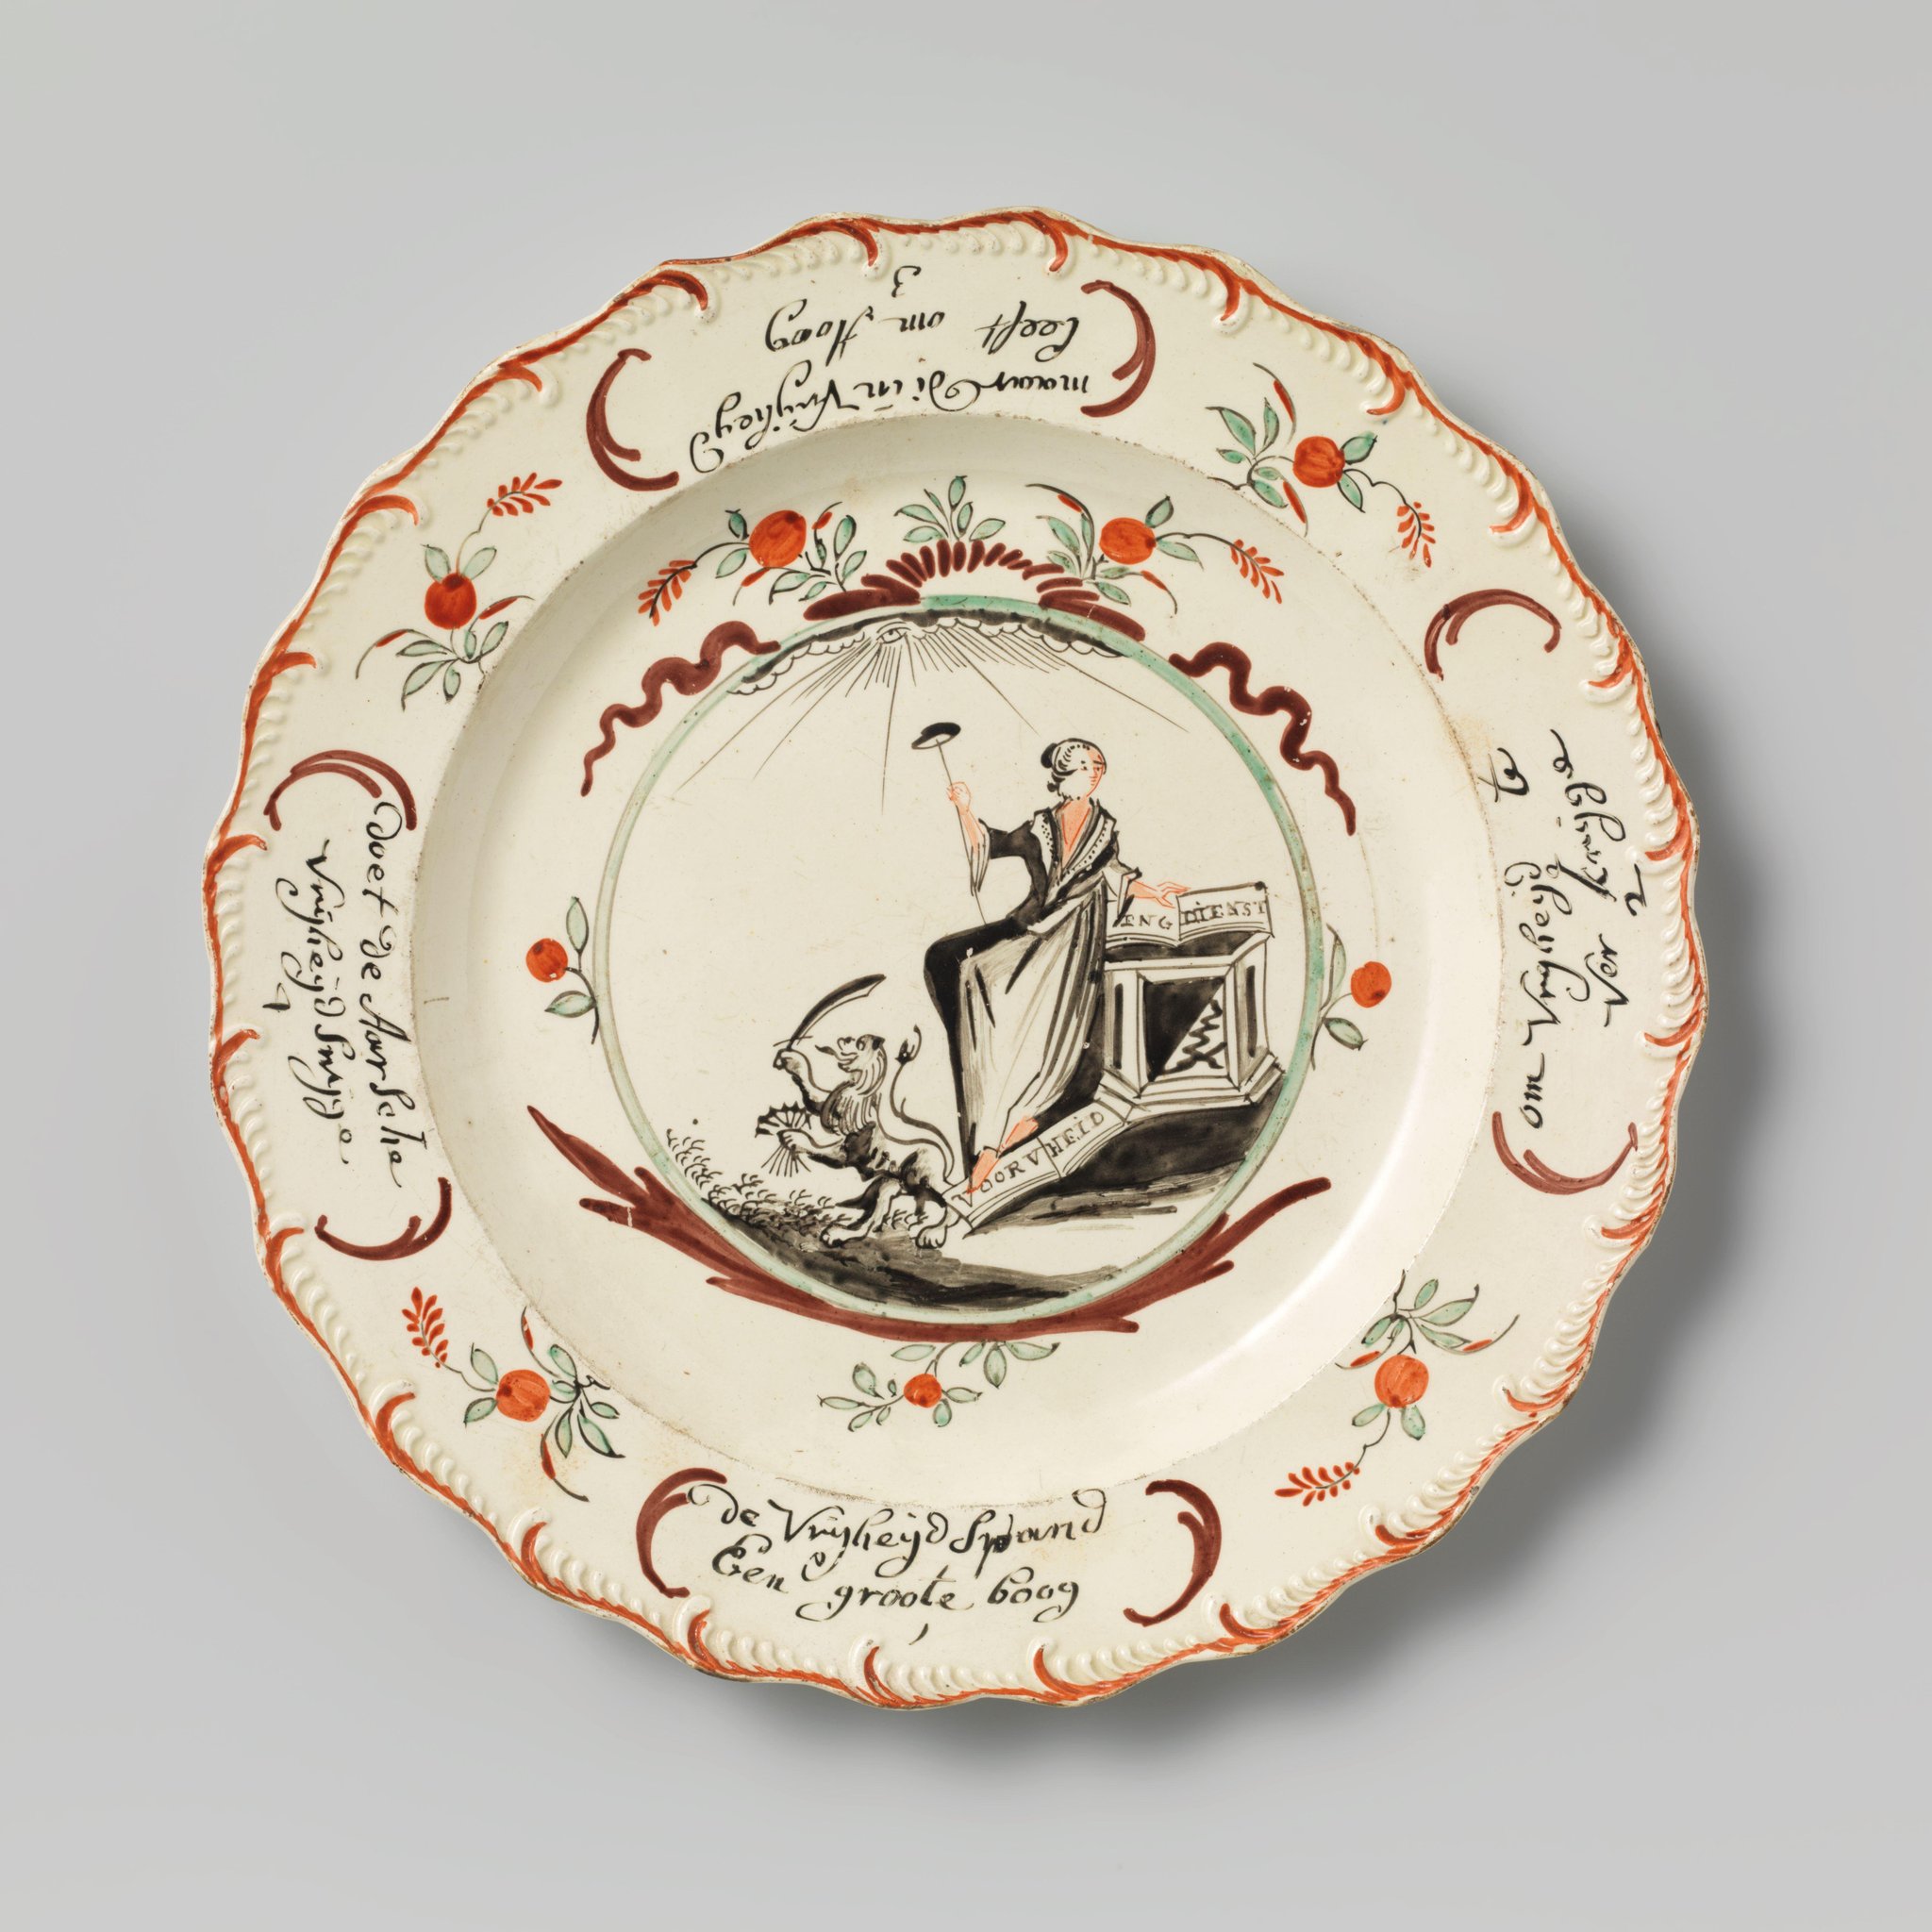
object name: plate dish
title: De vrijheid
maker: Anonymous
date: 1780-1790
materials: earthenware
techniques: firing, vitrification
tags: personifications of countries, nations, states, districts, etc., beasts of prey, predatory animals: lion (+ heraldic animals), freedom, liberty; 'libertà' (ripa) (+ abstract concept represented by female figure)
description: Sierbord met op het plat een 'Pro Patria'-tafereel met leeuw en Nederlandse maagd. Onder de maagd: 'VOOR VHEID' en 'ENG DIENST'. Op de rand gelijkmatig verdeeld vier dichtregels: 'de Vrijheid spand Een groote boog', 'om vrijheid te verkrijge', 'maar di in vrijheyd leeft omhoog', 'doet de Aarsche vrijheyd krijge'. De kleuring is bruin-groen-rood, versiering takken, bladeren en vruchten (appeltjes van Oranje?). Sticker achterop: Leeds en Turner 1780.